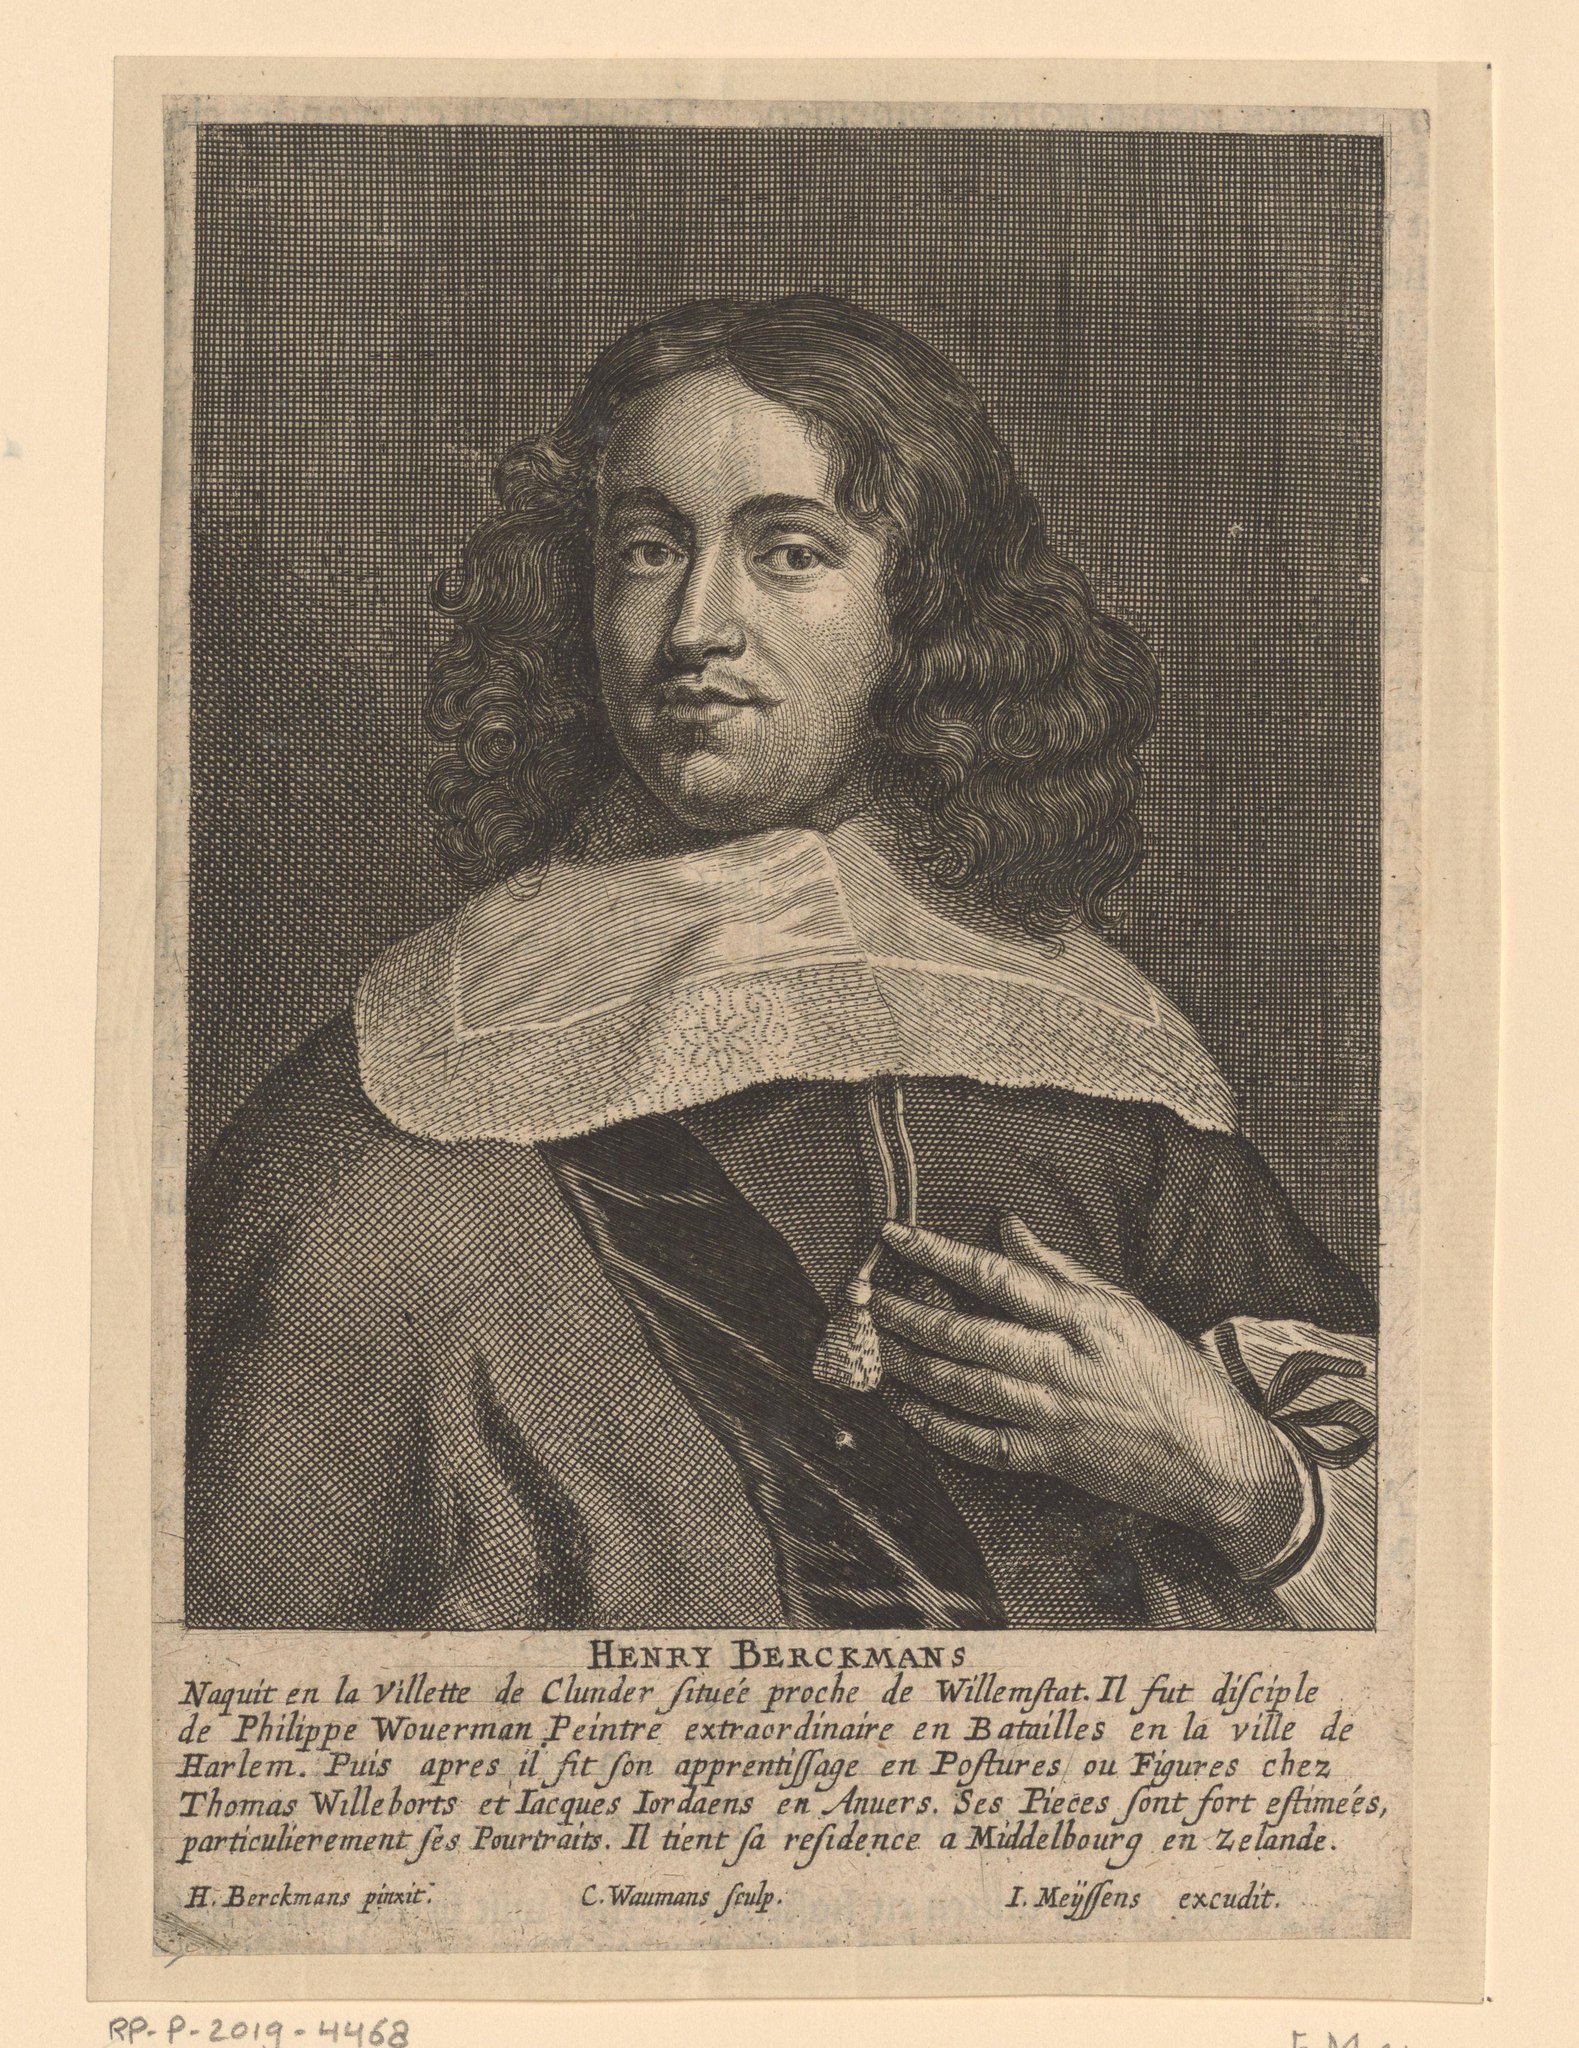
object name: book illustration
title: Portret van Hendrick Berckman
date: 1662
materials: paper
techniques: engraving, letterpress printing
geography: antwerp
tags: hendrick berckman, historical persons, portrait, self-portrait of painter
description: Prent uit: Bie, Cornelis de. Het gulden cabinet vande edele vry schilder-const (...). Antwerpen: Juliaen van Montfort, 1662, p. 415.